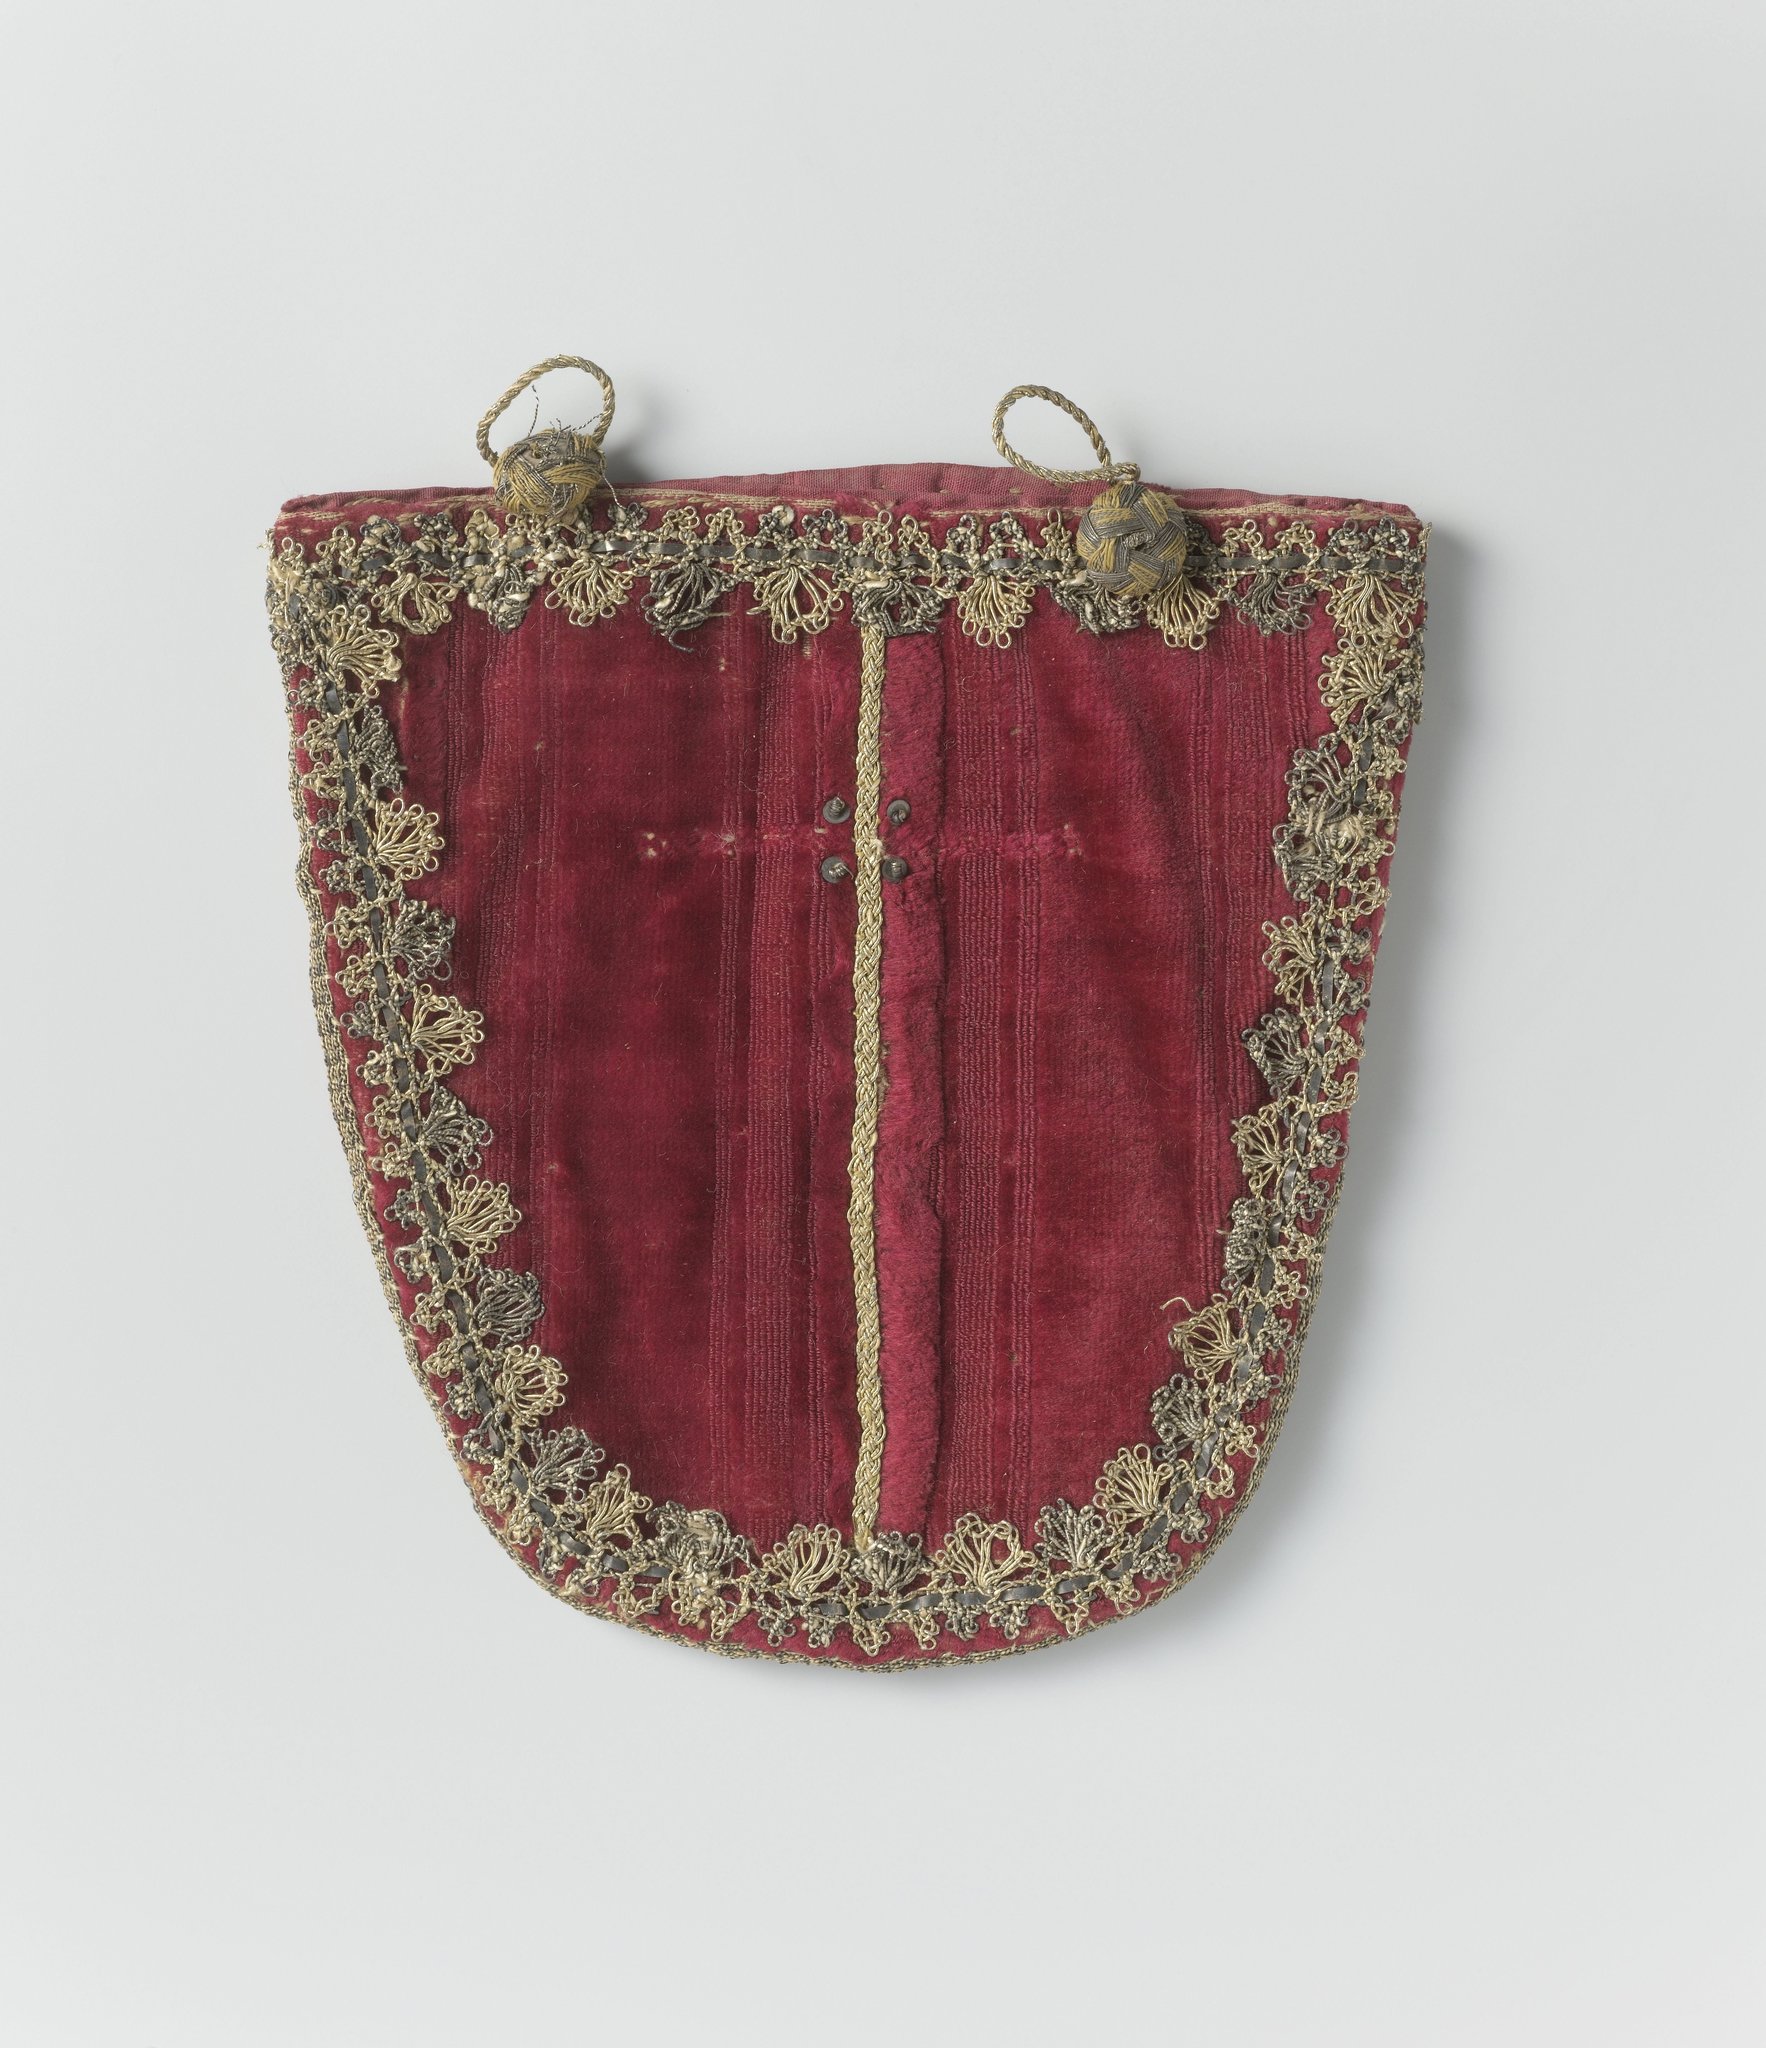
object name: beurs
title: Beurs in een plat model met tapstoelopende onderkant, van donkerrood fluweel waarop aan beide kanten langs de rand een strook goudkant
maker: Anonymous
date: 1600-1699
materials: gold thread, sequin, silk, velvet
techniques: braiding, weave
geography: europe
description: Beurs in een plat model met tapstoelopende onderkant, van donkerrood fluweel. Op beide kanten langs de rand een strook goudkant, waar een smalle baan metaal doorheen is geweven. Verticaal over het midden een gevochten goudkoord (waarschijnlijk oorspronkelijk gekruist met een horizontaal koord) met in de vier hoeken vier metalen lovers. De beurs sluit door twee lussen en twee knopen aan de bovenrand. De voering is van rode tafzijde.